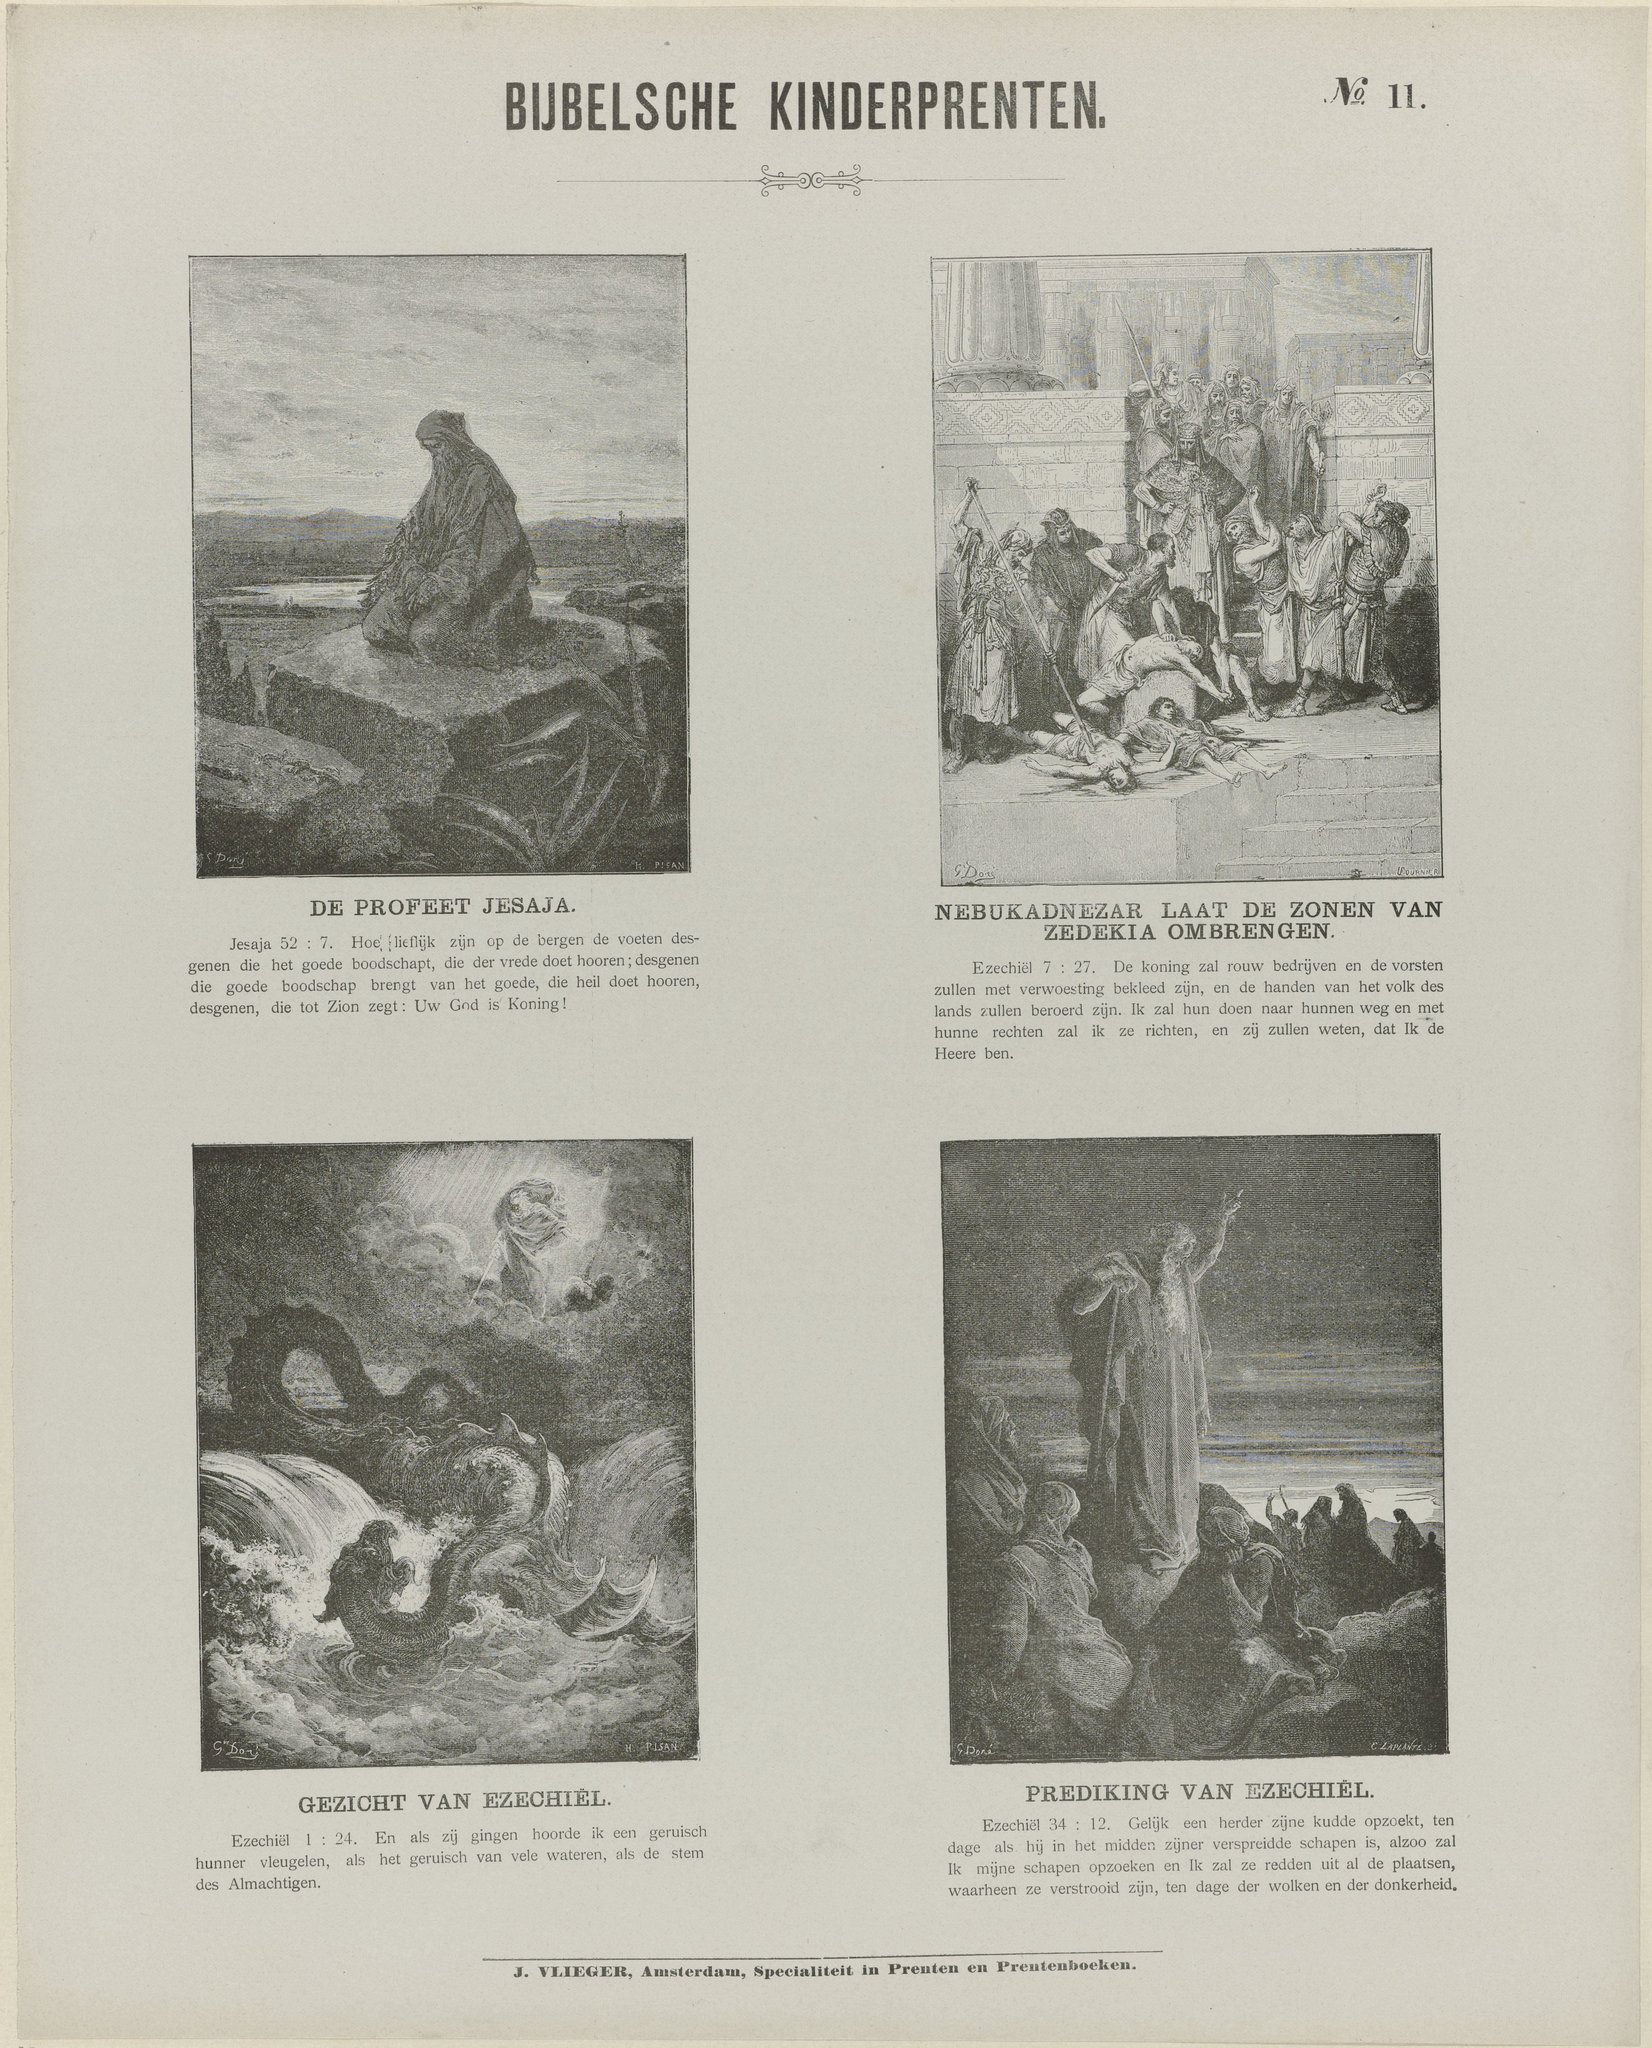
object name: print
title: Bijbelsche kinderprenten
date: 1869-1908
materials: paper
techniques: letterpress printing, photoaquatint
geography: amsterdam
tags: ezekiel preaching, pharaoh, as a dragon or a crocodile, falls upon the open fields ~ ezekiel's prophecies, old testament, the book of isaiah, zedekiah's sons are put to death while he looks on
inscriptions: collector's mark: Lugt 2760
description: Blad met 4 voorstellingen van verhalen uit het Oude Testament. De profeet Jesaja op een rots, Nebukadnessar laat de zonen van Sedekia ombrengen, de farao in de gedaante van een draak in strijd met Ezechiël en Ezechiël die predikt. Onder elke afbeelding een Bijbeltekst. Genummerd rechtsboven: No. 11.